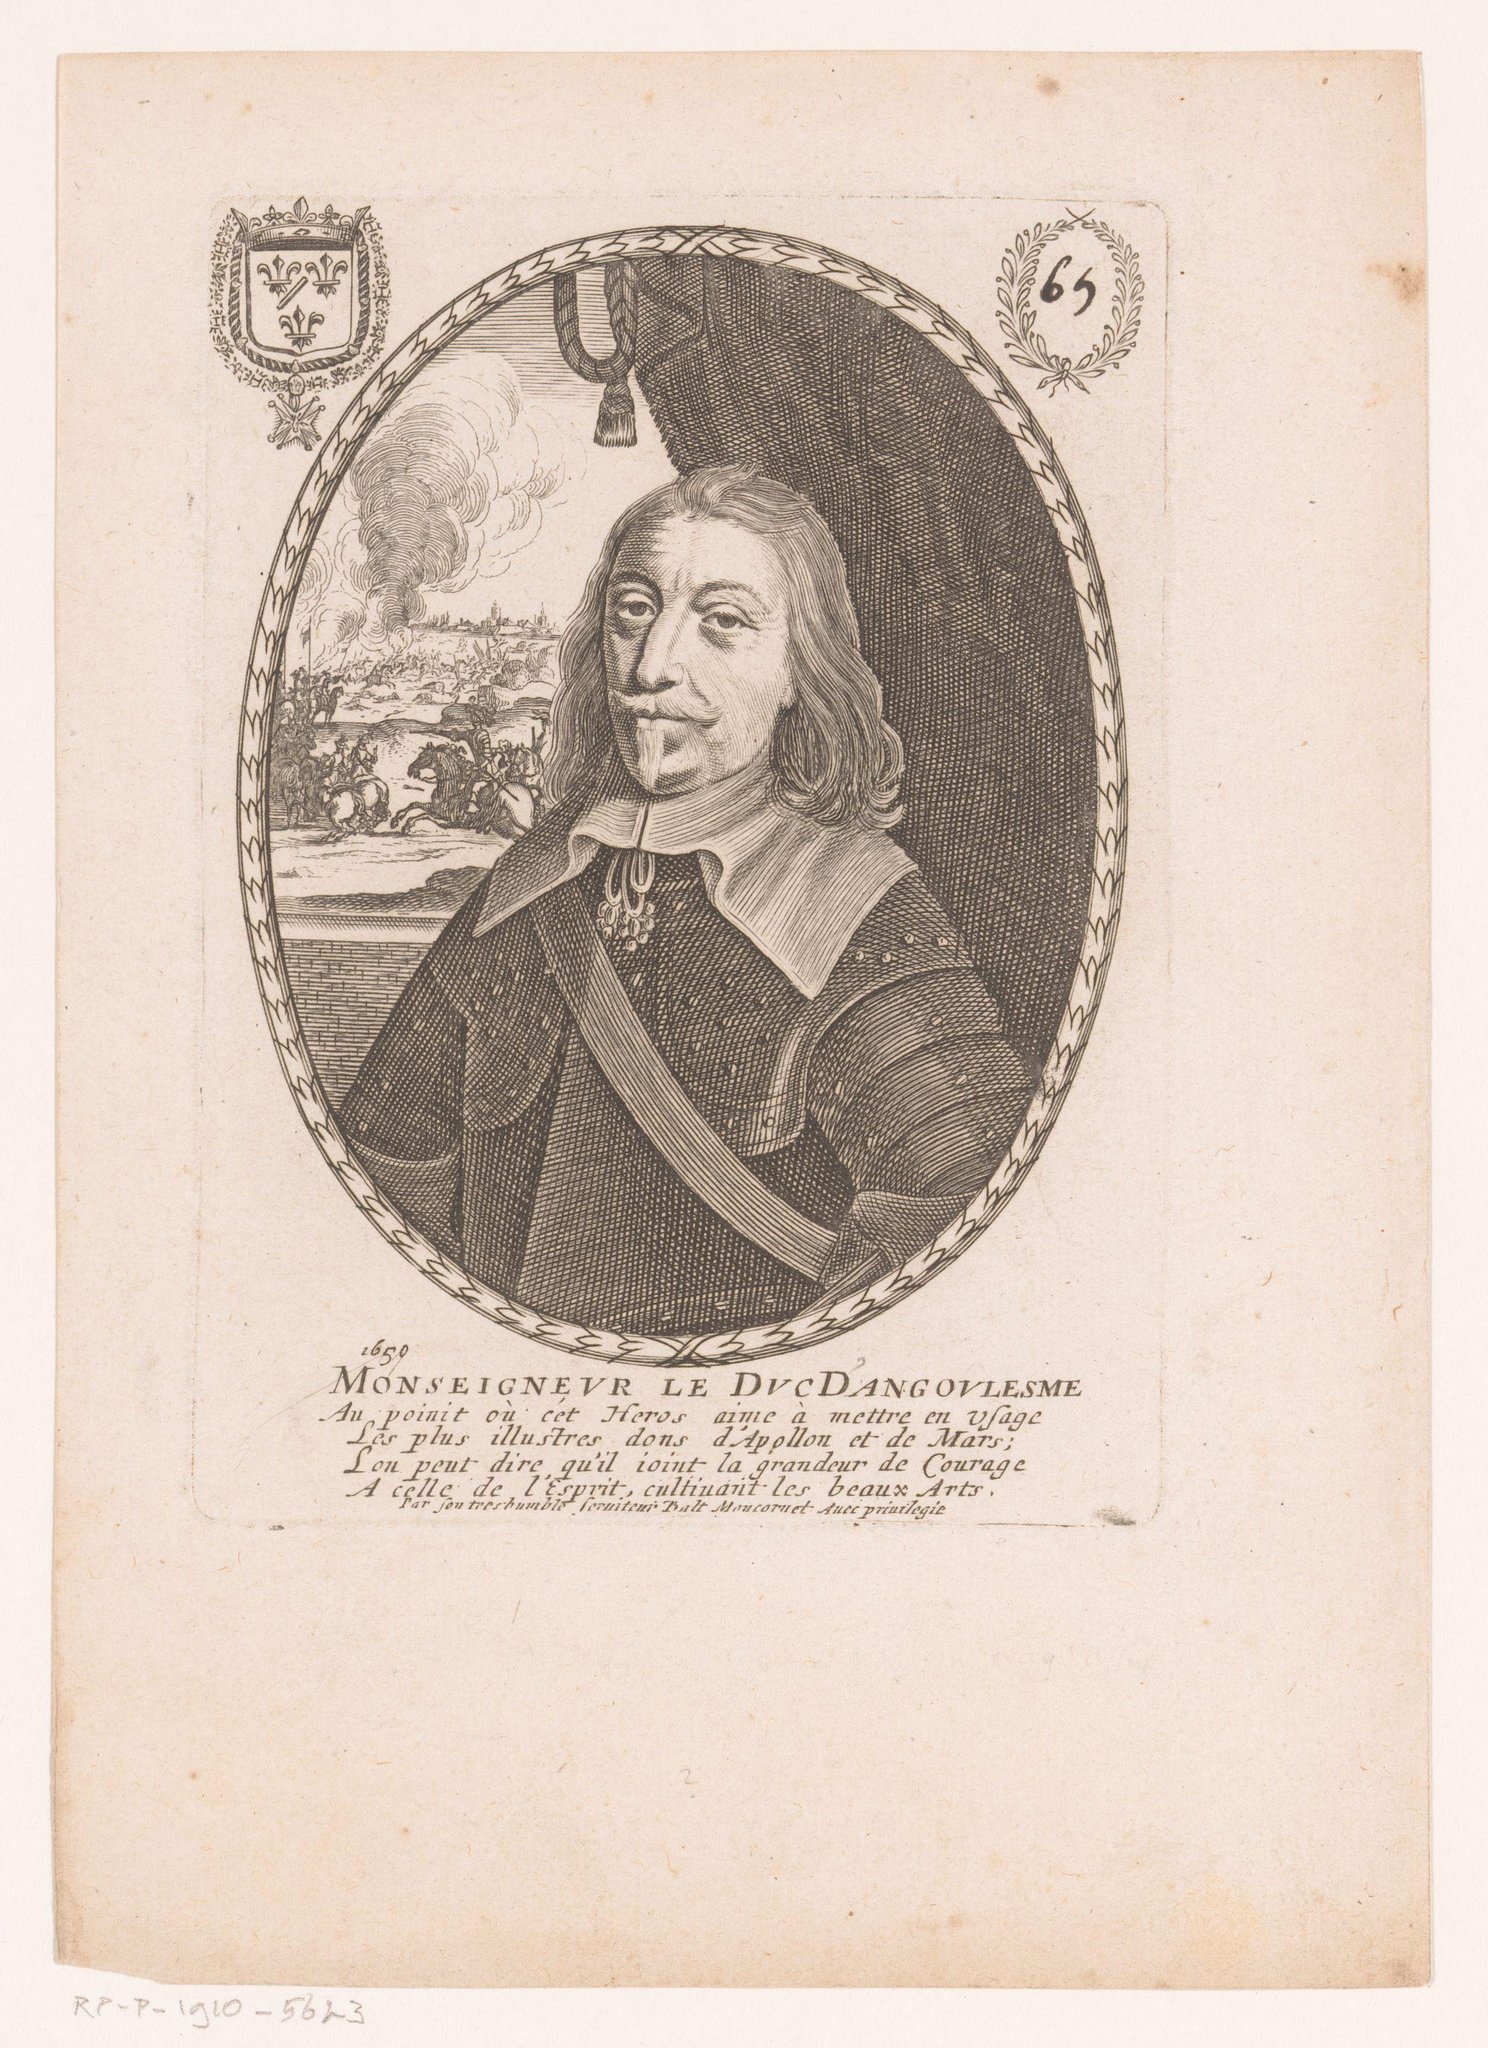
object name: print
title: Portret van Charles d'Angoulême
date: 1659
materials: paper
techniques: engraving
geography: paris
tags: charles de valois (hertog van angoulême), historical persons, armorial bearing, heraldry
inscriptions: number: ‘65’, collector's mark: Lugt 2228